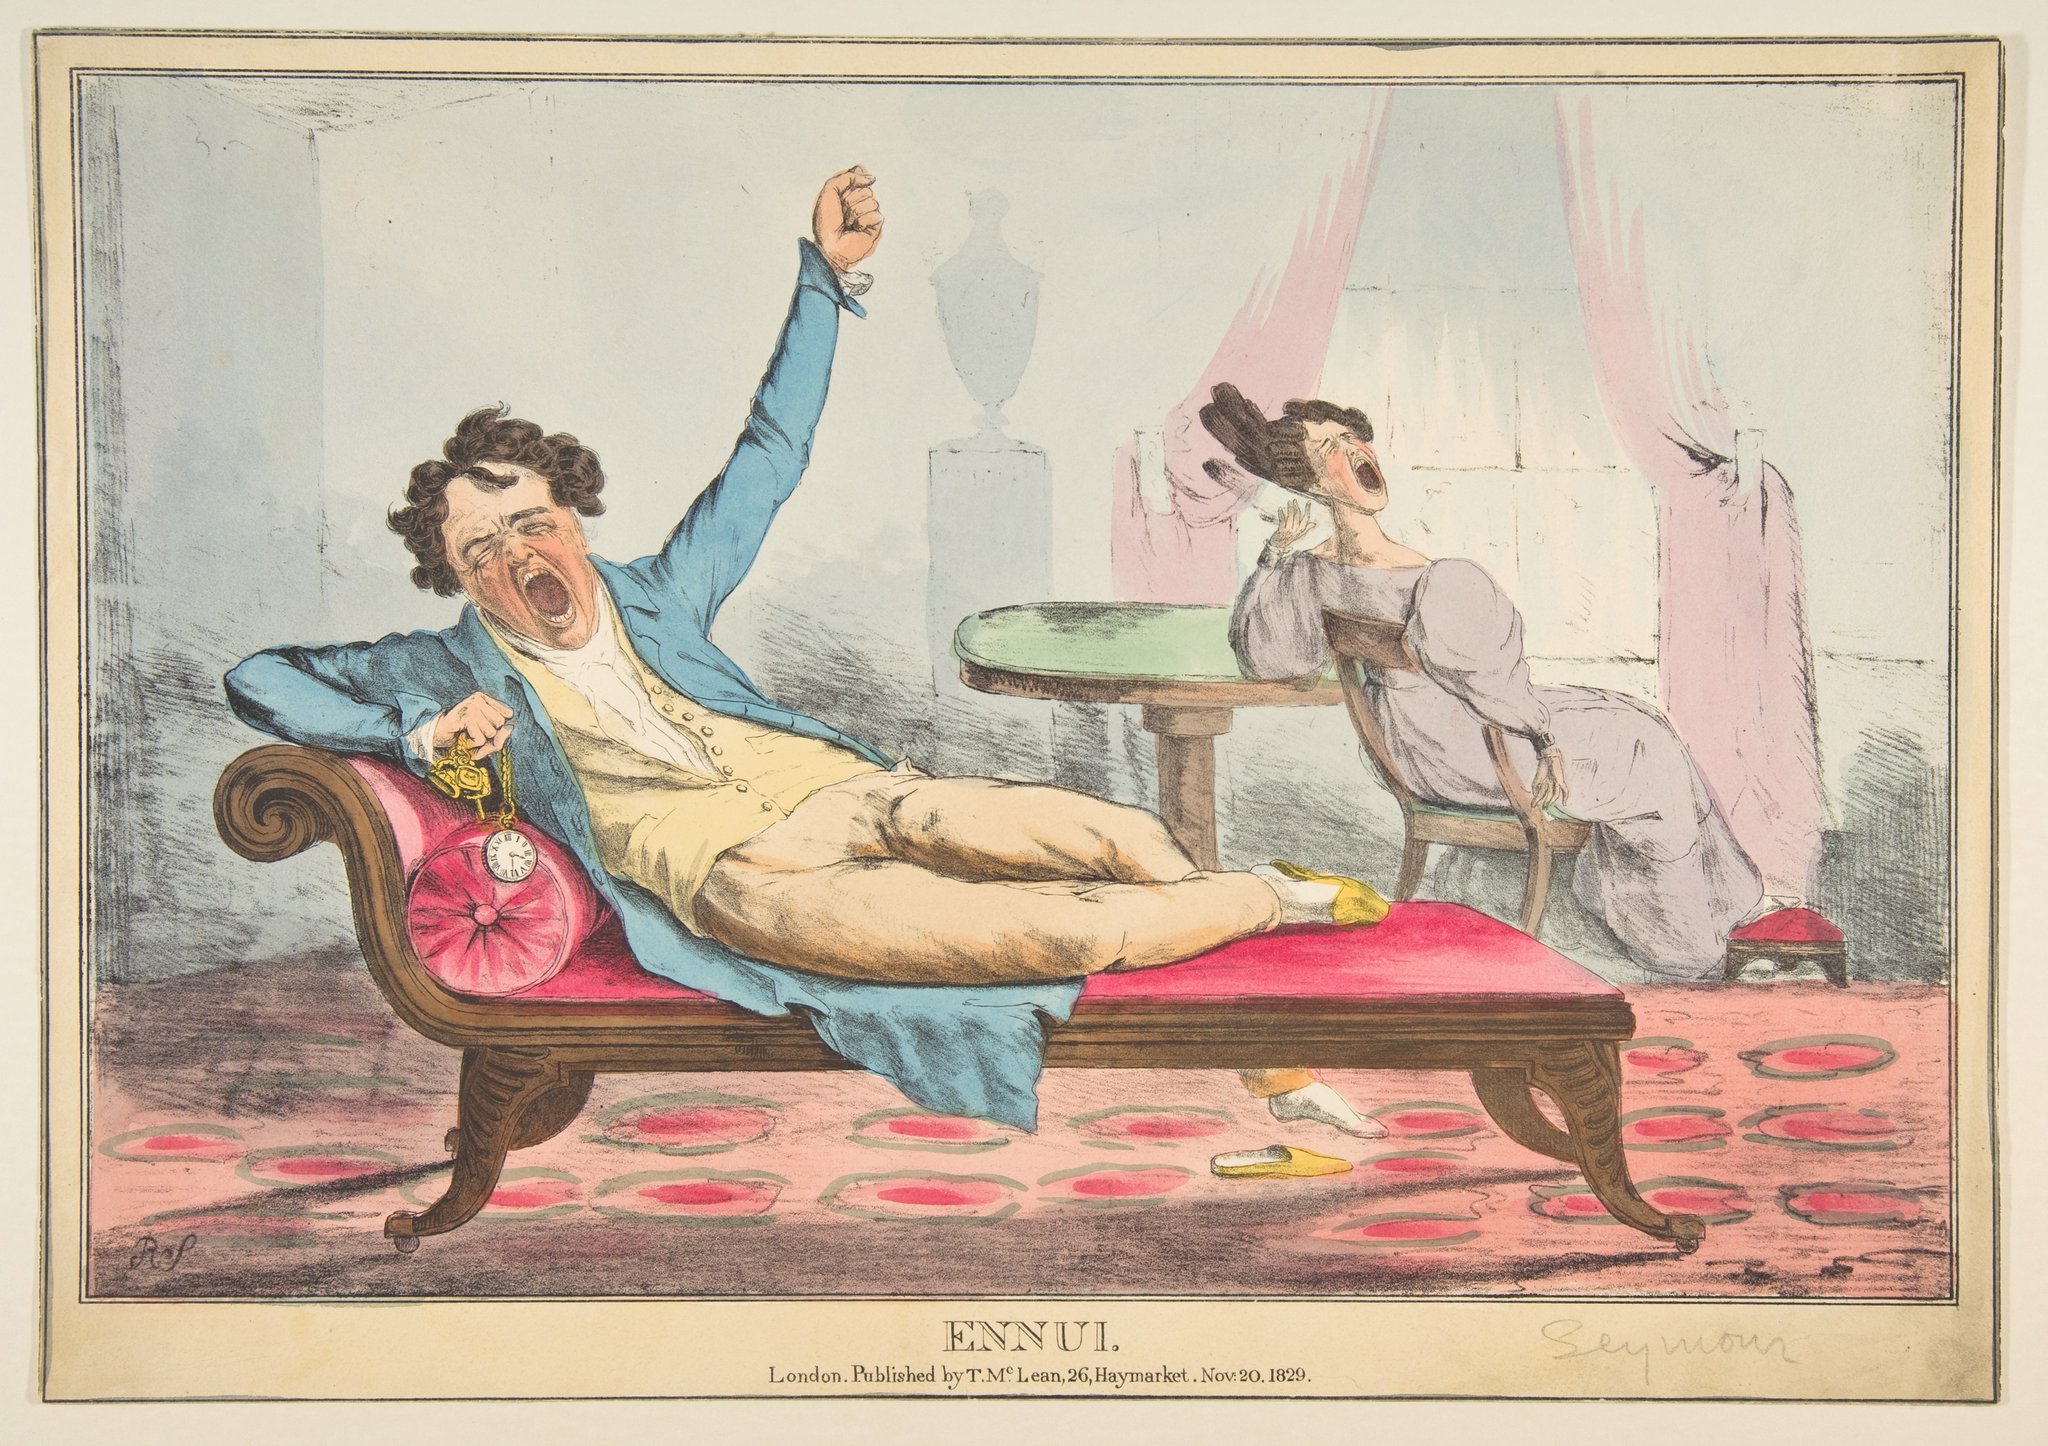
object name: print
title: Ennui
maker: robert seymour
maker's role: artist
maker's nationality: british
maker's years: 1798-1836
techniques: hand coloring, lithograph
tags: satire,men,women,couches